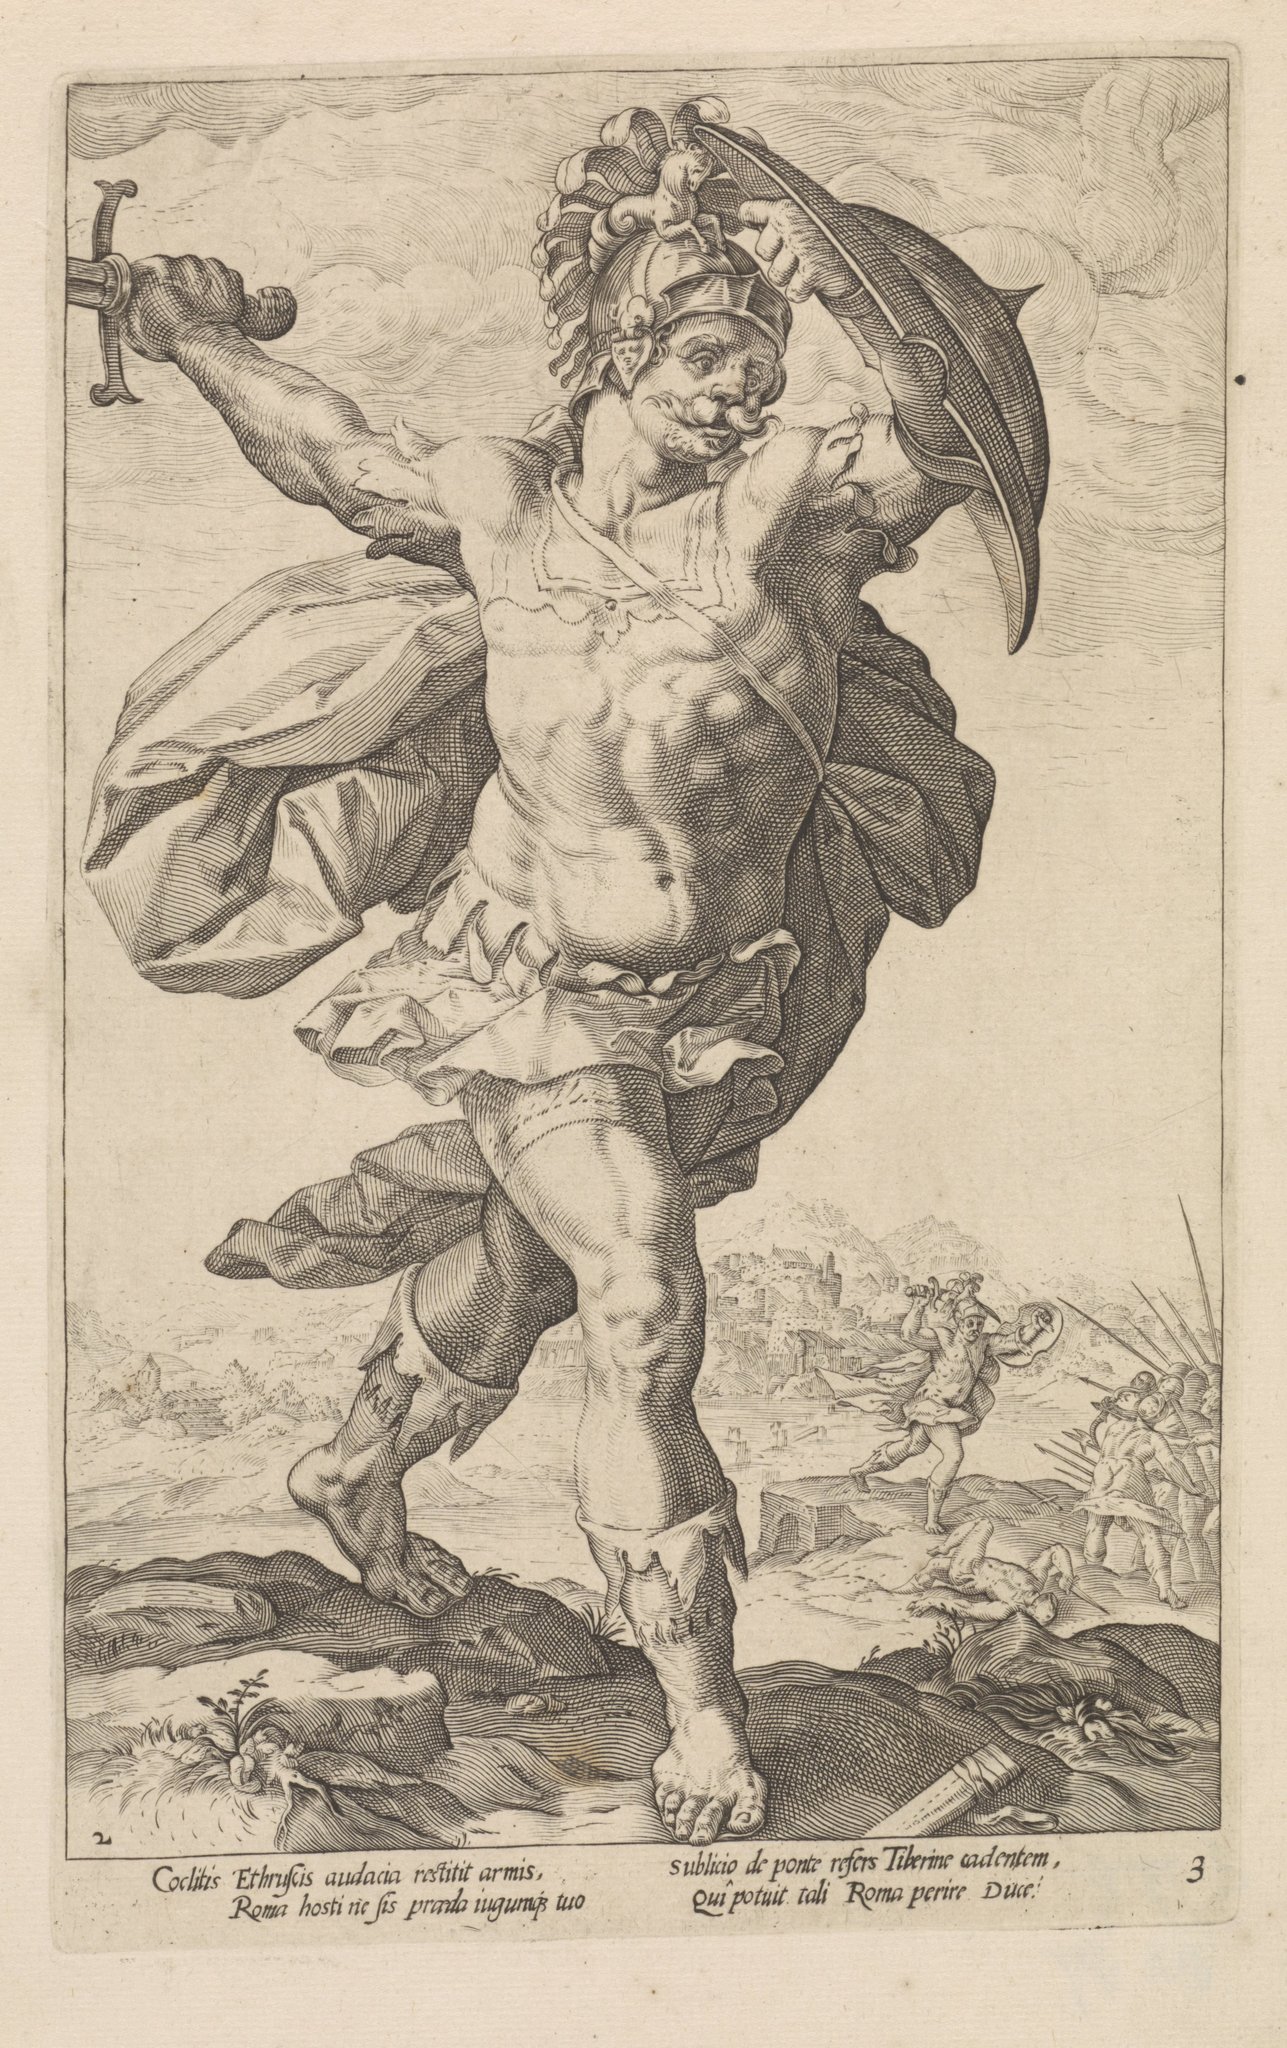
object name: print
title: Romeinse helden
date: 1645-1706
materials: paper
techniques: engraving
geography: amsterdam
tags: horatius cocles at the pons sublicius: single-handed he keeps the etruscans at bay while the bridge is broken down by the romans behind him; he escapes by jumping into the tiber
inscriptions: collector's mark: Lugt 2228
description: De held Horatius Cocles ten voeten uit, een zwaard opgeheven in de rechterhand, een schild in de linkerhand. Op de achtergrond is te zien hoe hij het op de oever van de Tiber in zijn eentje opneemt tegen een heel leger. Onder de voorstelling twee maal twee versregels in Latijn.